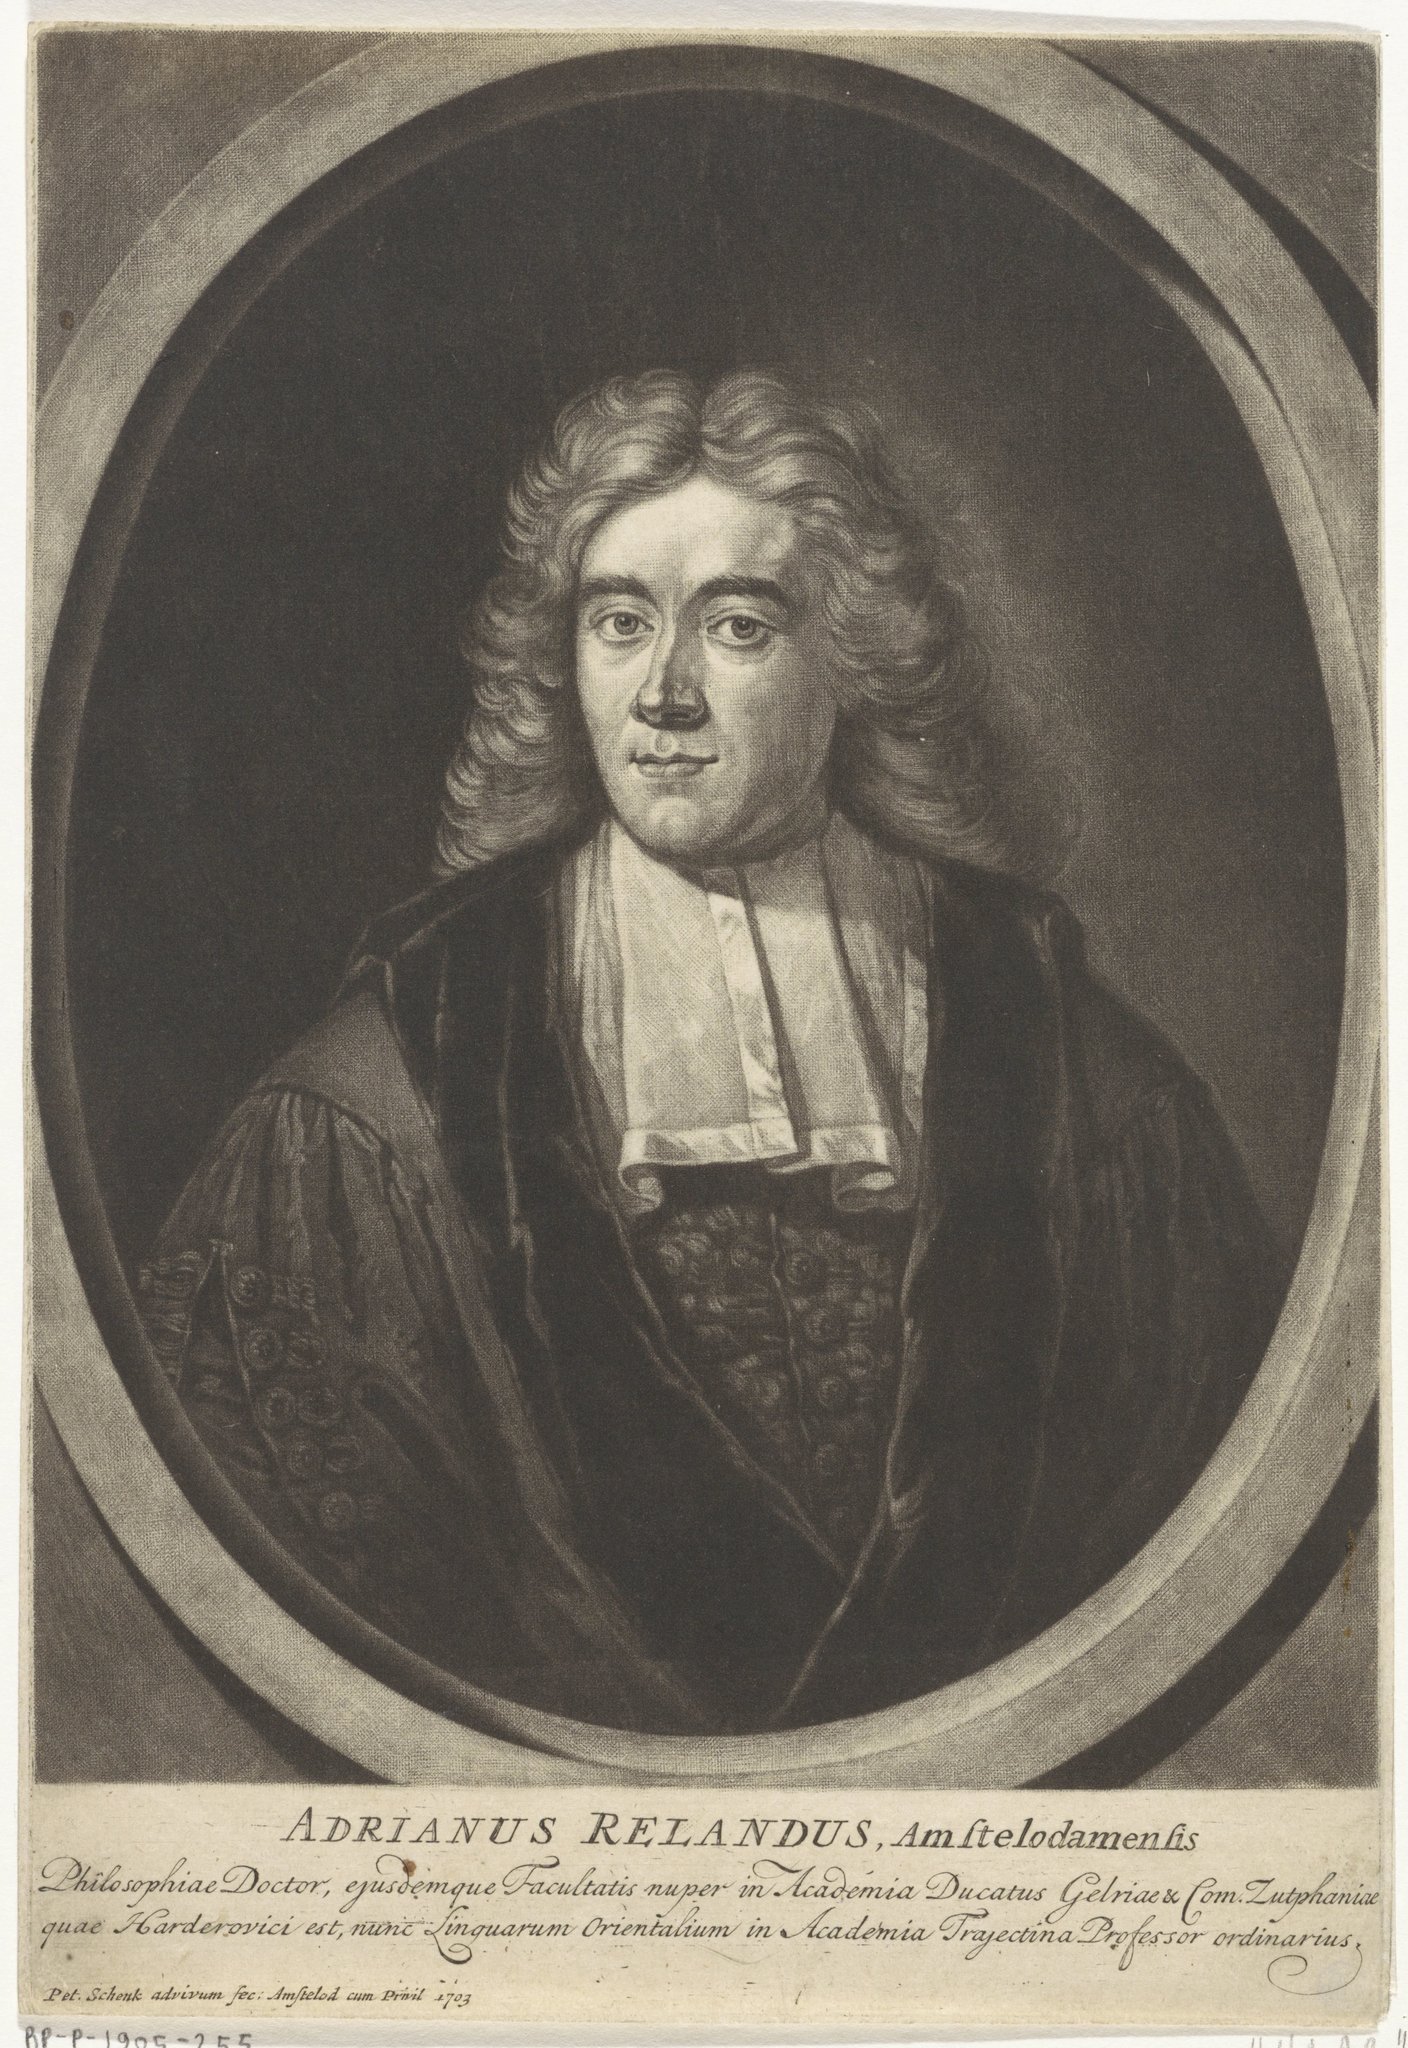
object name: print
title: Portret van Adriaan Reland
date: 1703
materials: paper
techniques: engraving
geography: amsterdam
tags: utrecht, adriaan reeland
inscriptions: collector's mark: Lugt 2228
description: Borstbeeld van de hoogleraar Adriaan Reland met toga.